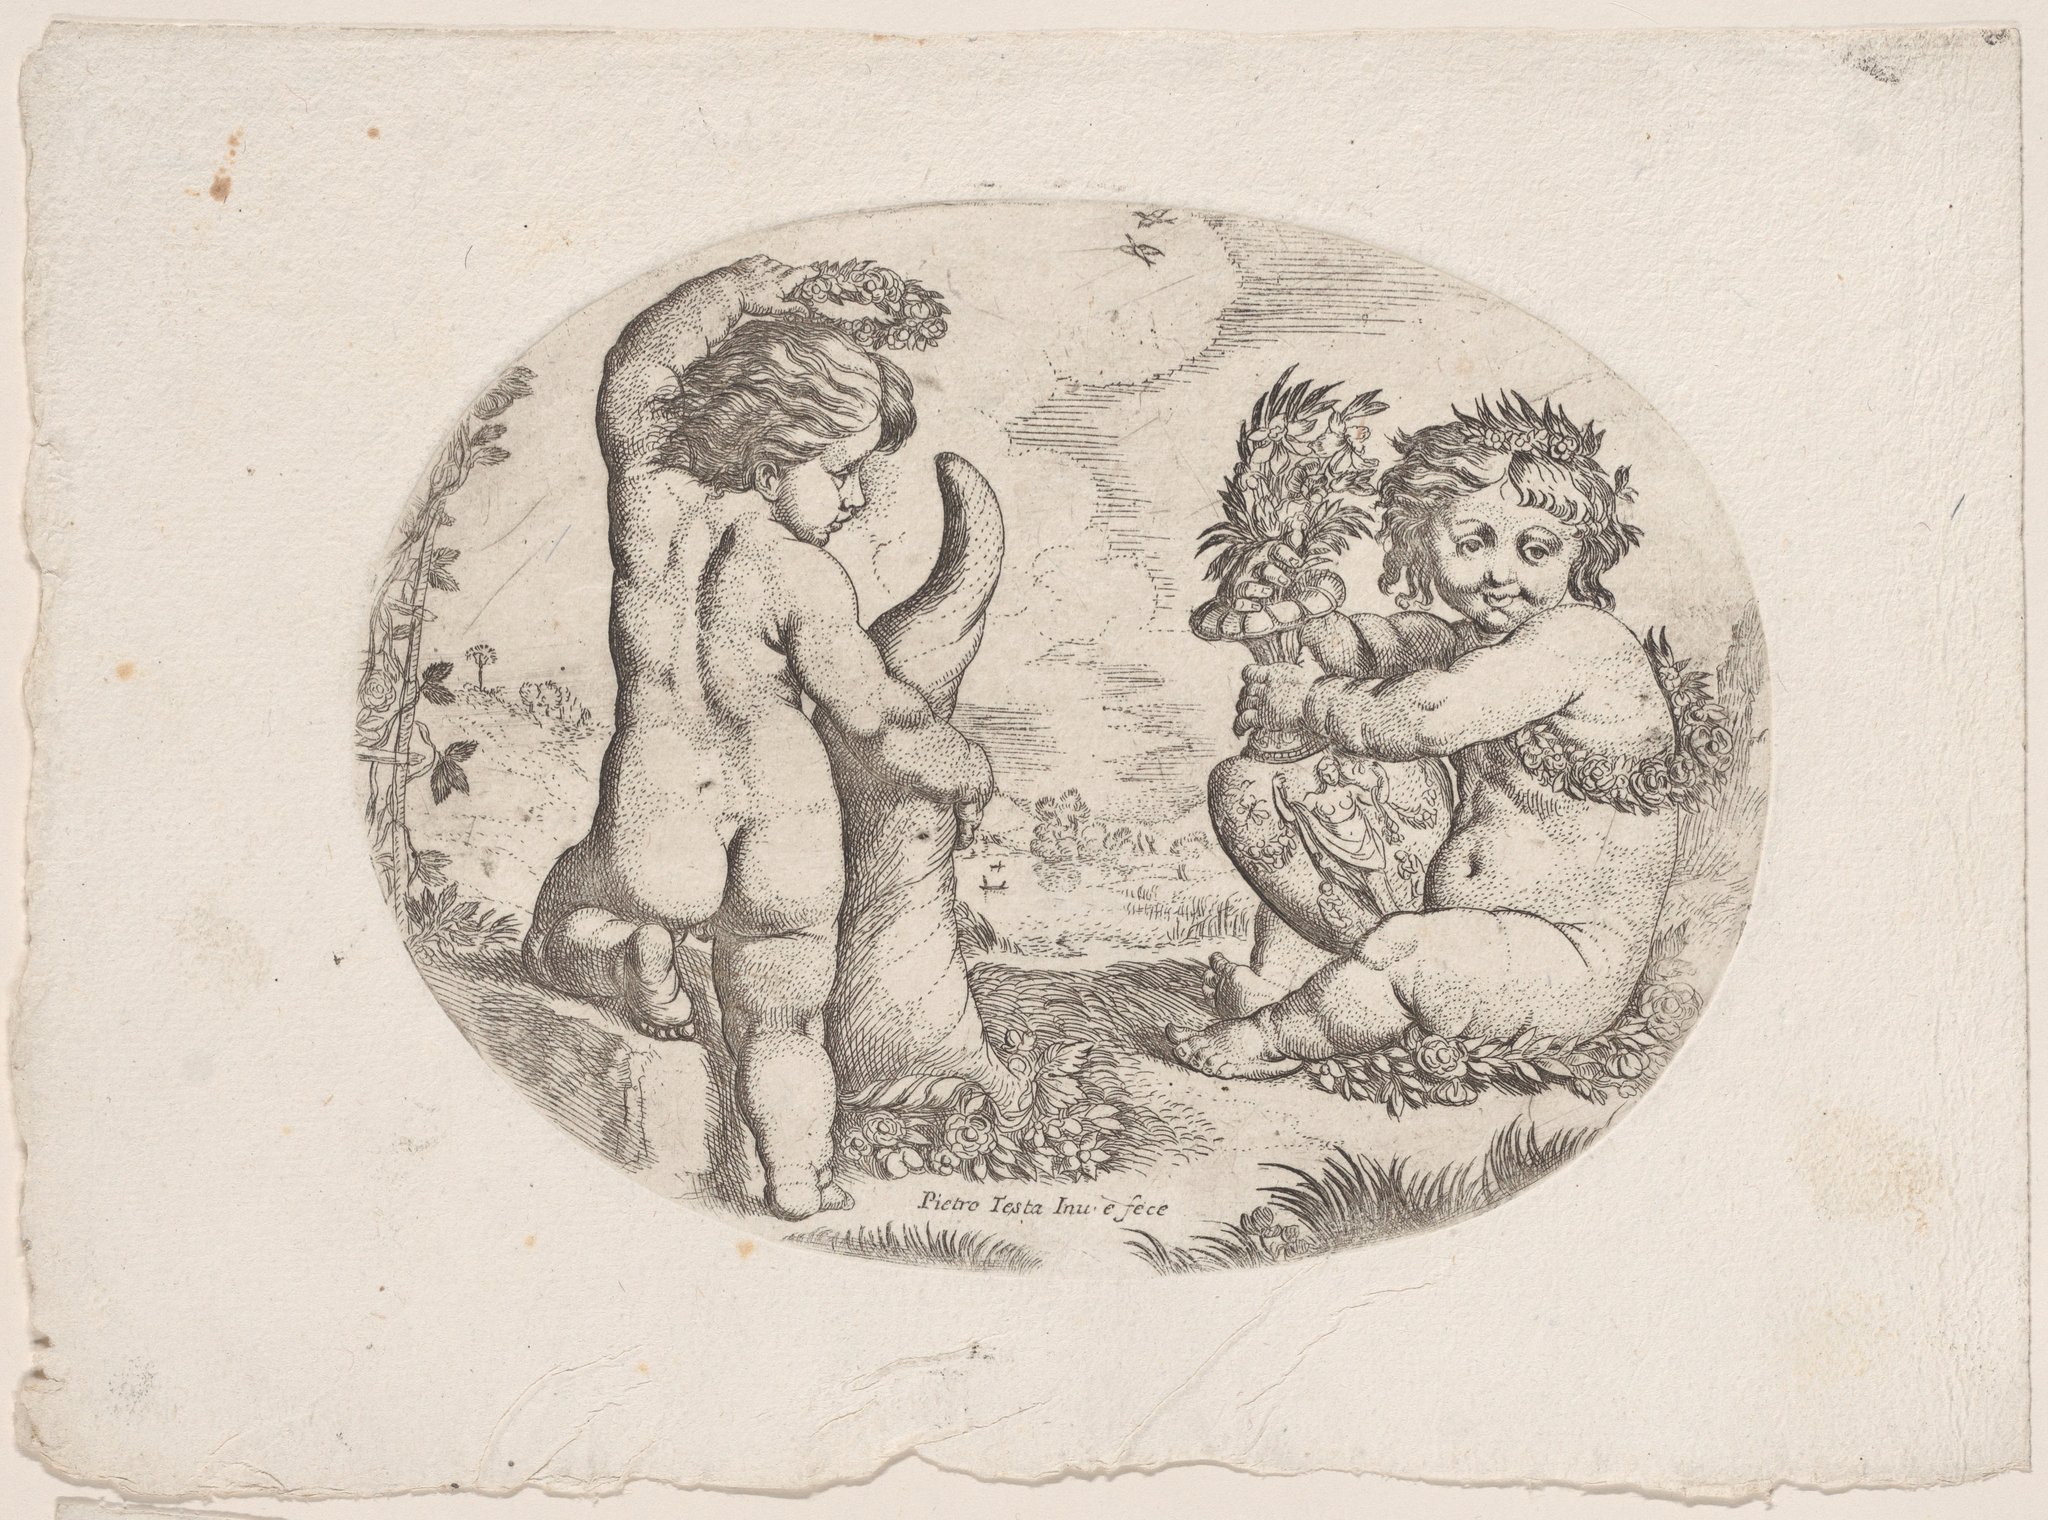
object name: print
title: Putto at left holding an upturned cornucopia and a garland, another seated at the right holding an urn, an allegory of the seasons (Autumn), an oval composition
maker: anonymous, 17th century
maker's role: artist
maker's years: 1600-1700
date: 1650-1680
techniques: etching